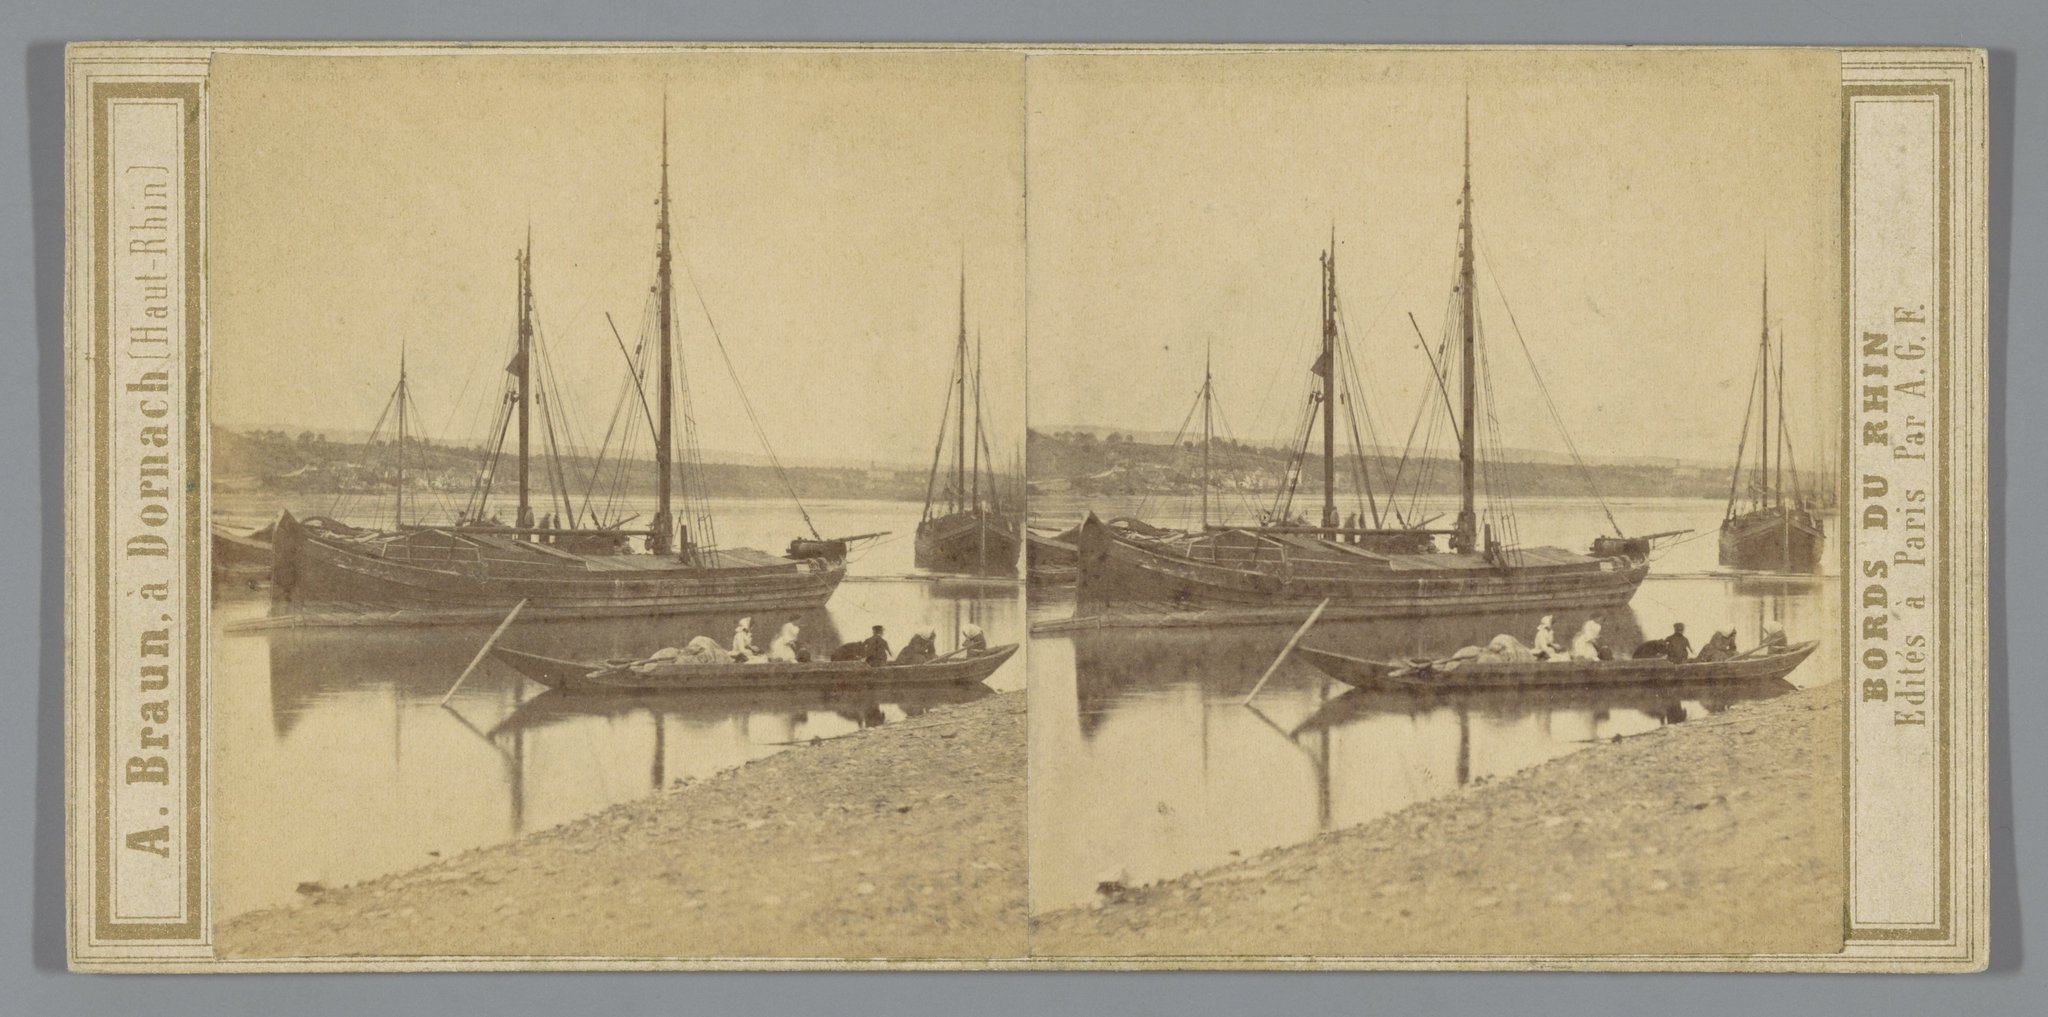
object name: stereograph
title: Gezicht op schepen op de Rijn nabij Andernach, Duitsland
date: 1860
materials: cardboard, paper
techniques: albumen print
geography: andernach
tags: river, ships (in general) - cc - more than one ship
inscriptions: number: ‘816.’, number: ‘79’, inscription: ‘6 16 6 de Ranctz [?]’